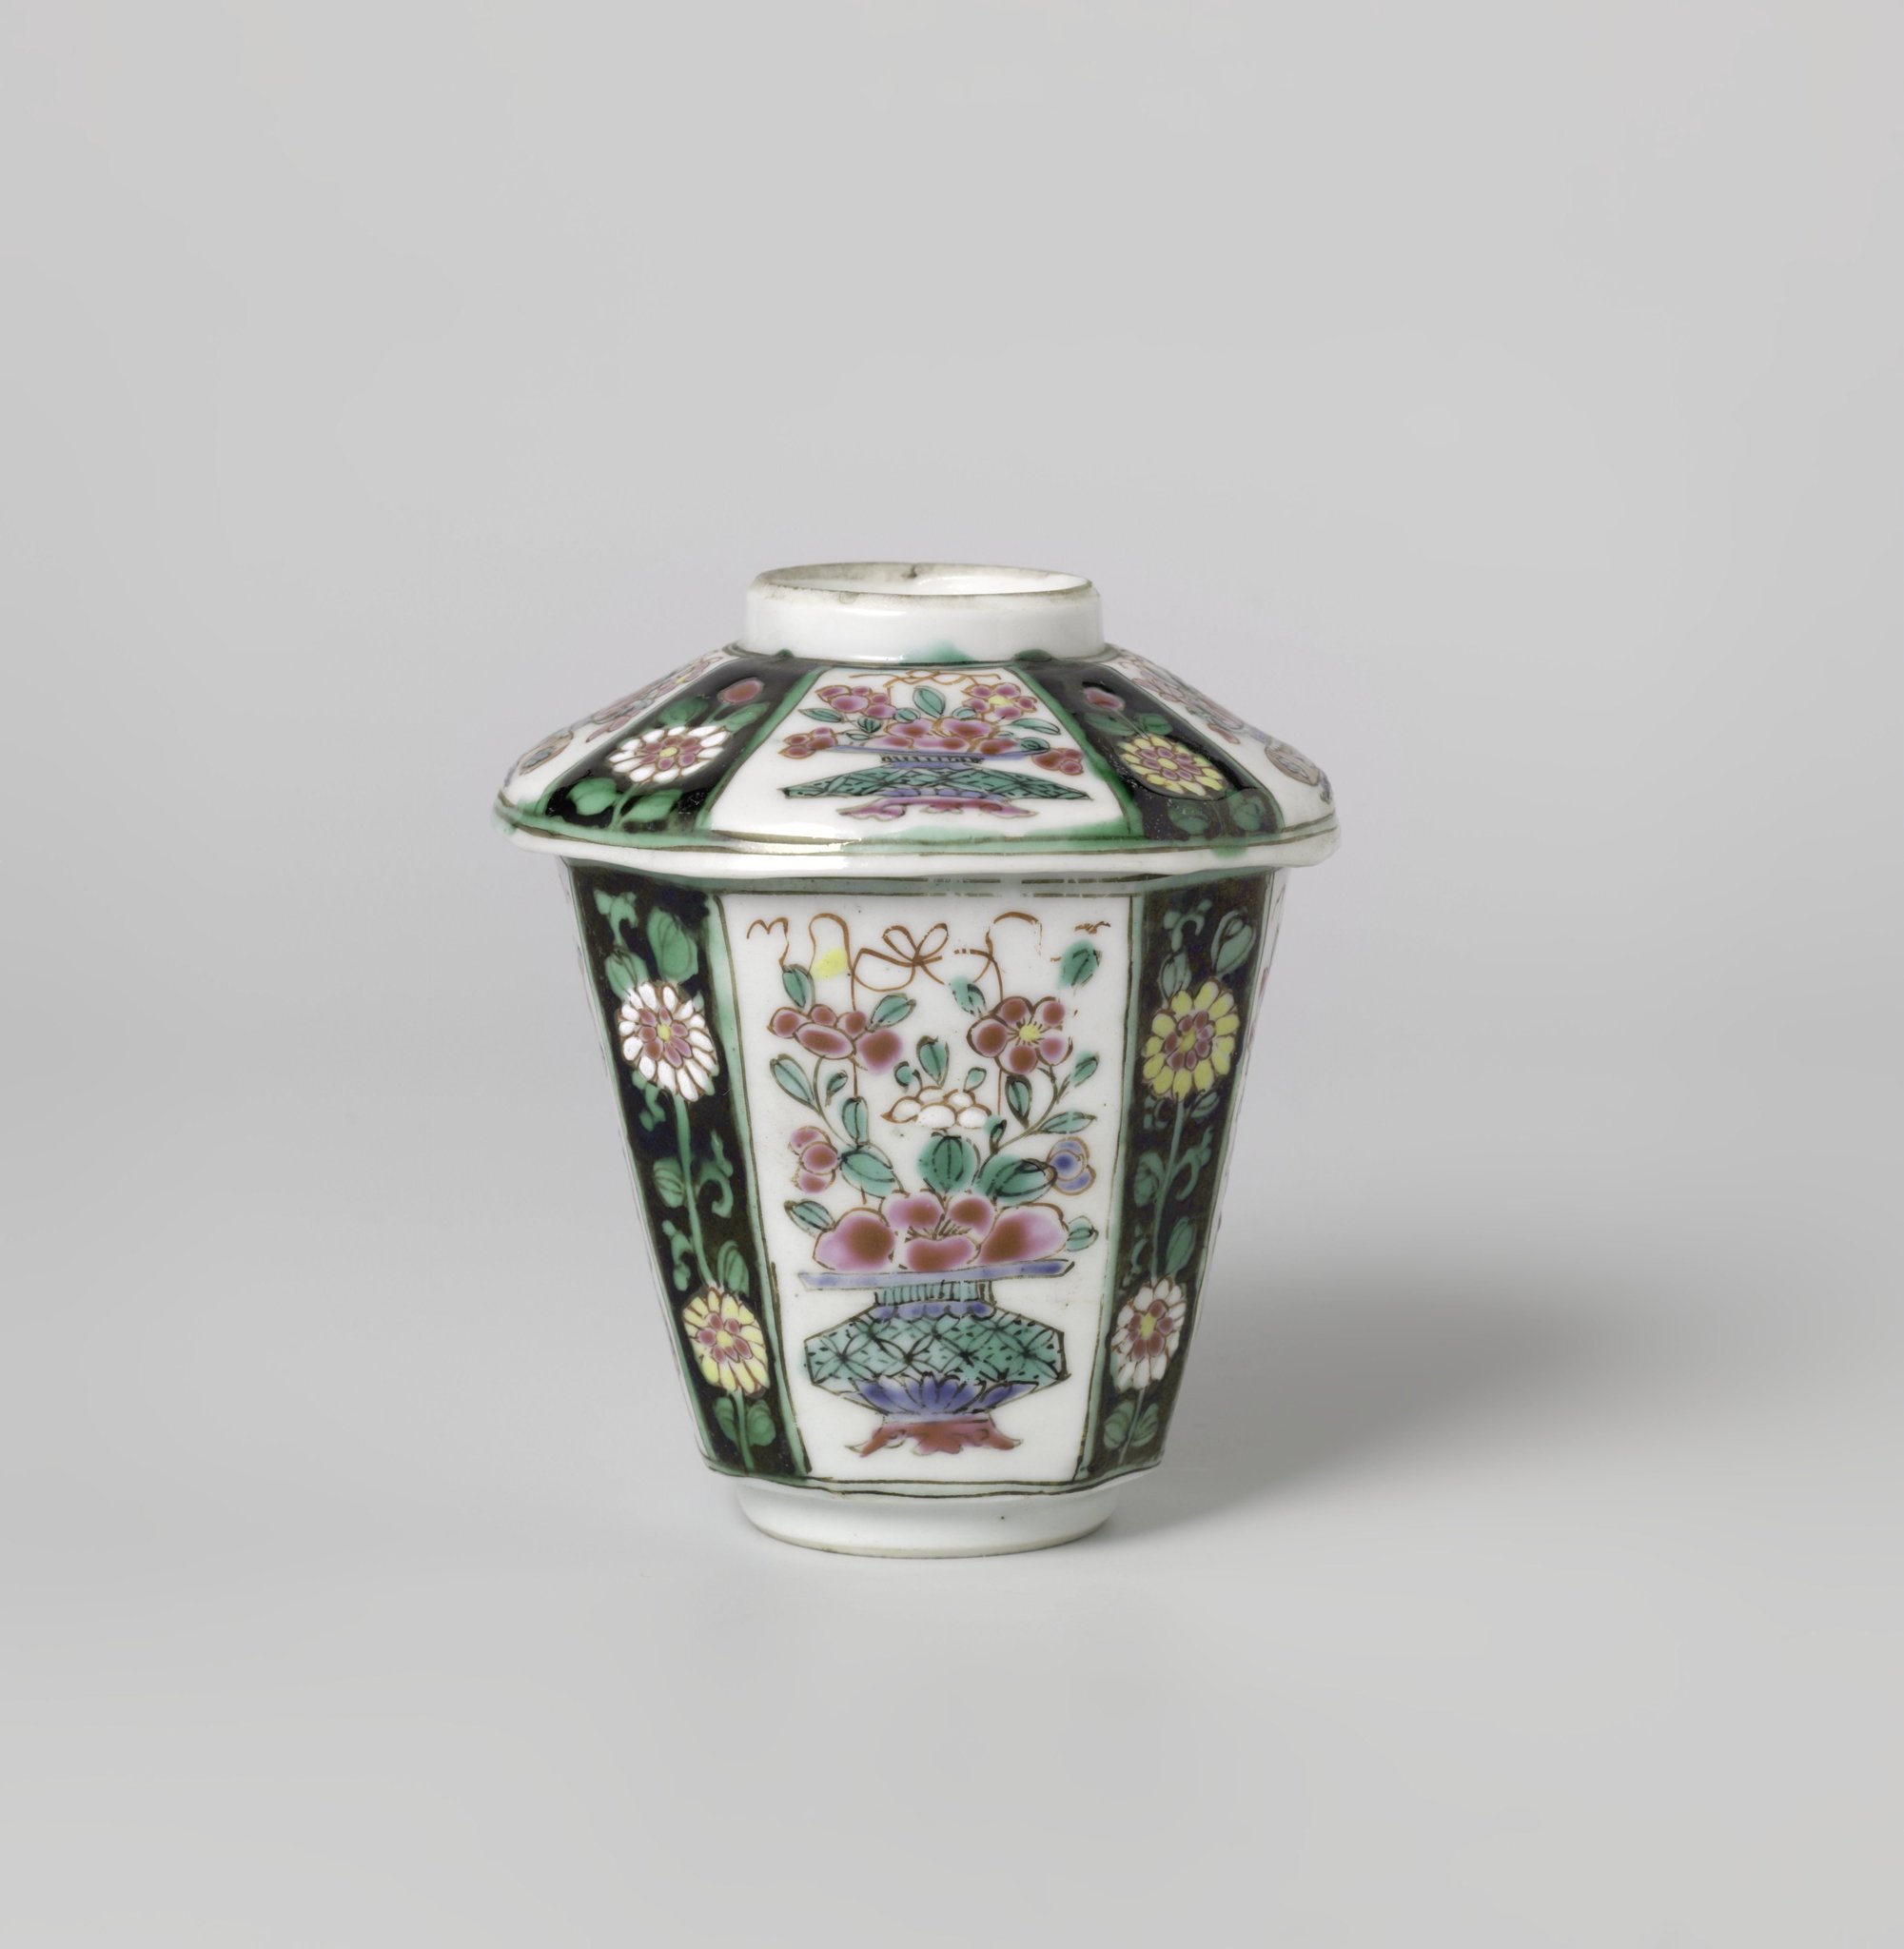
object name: kop en schotel, kop en schotel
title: Covered cup with flower baskets and floral scolls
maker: Anonymous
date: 1750-1774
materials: glaze, paint, porcelain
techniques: firing, turning, vitrification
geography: china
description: Kop en schotel met deksel, famille rose kleuren en zwart met bloemen en bloemvazen.